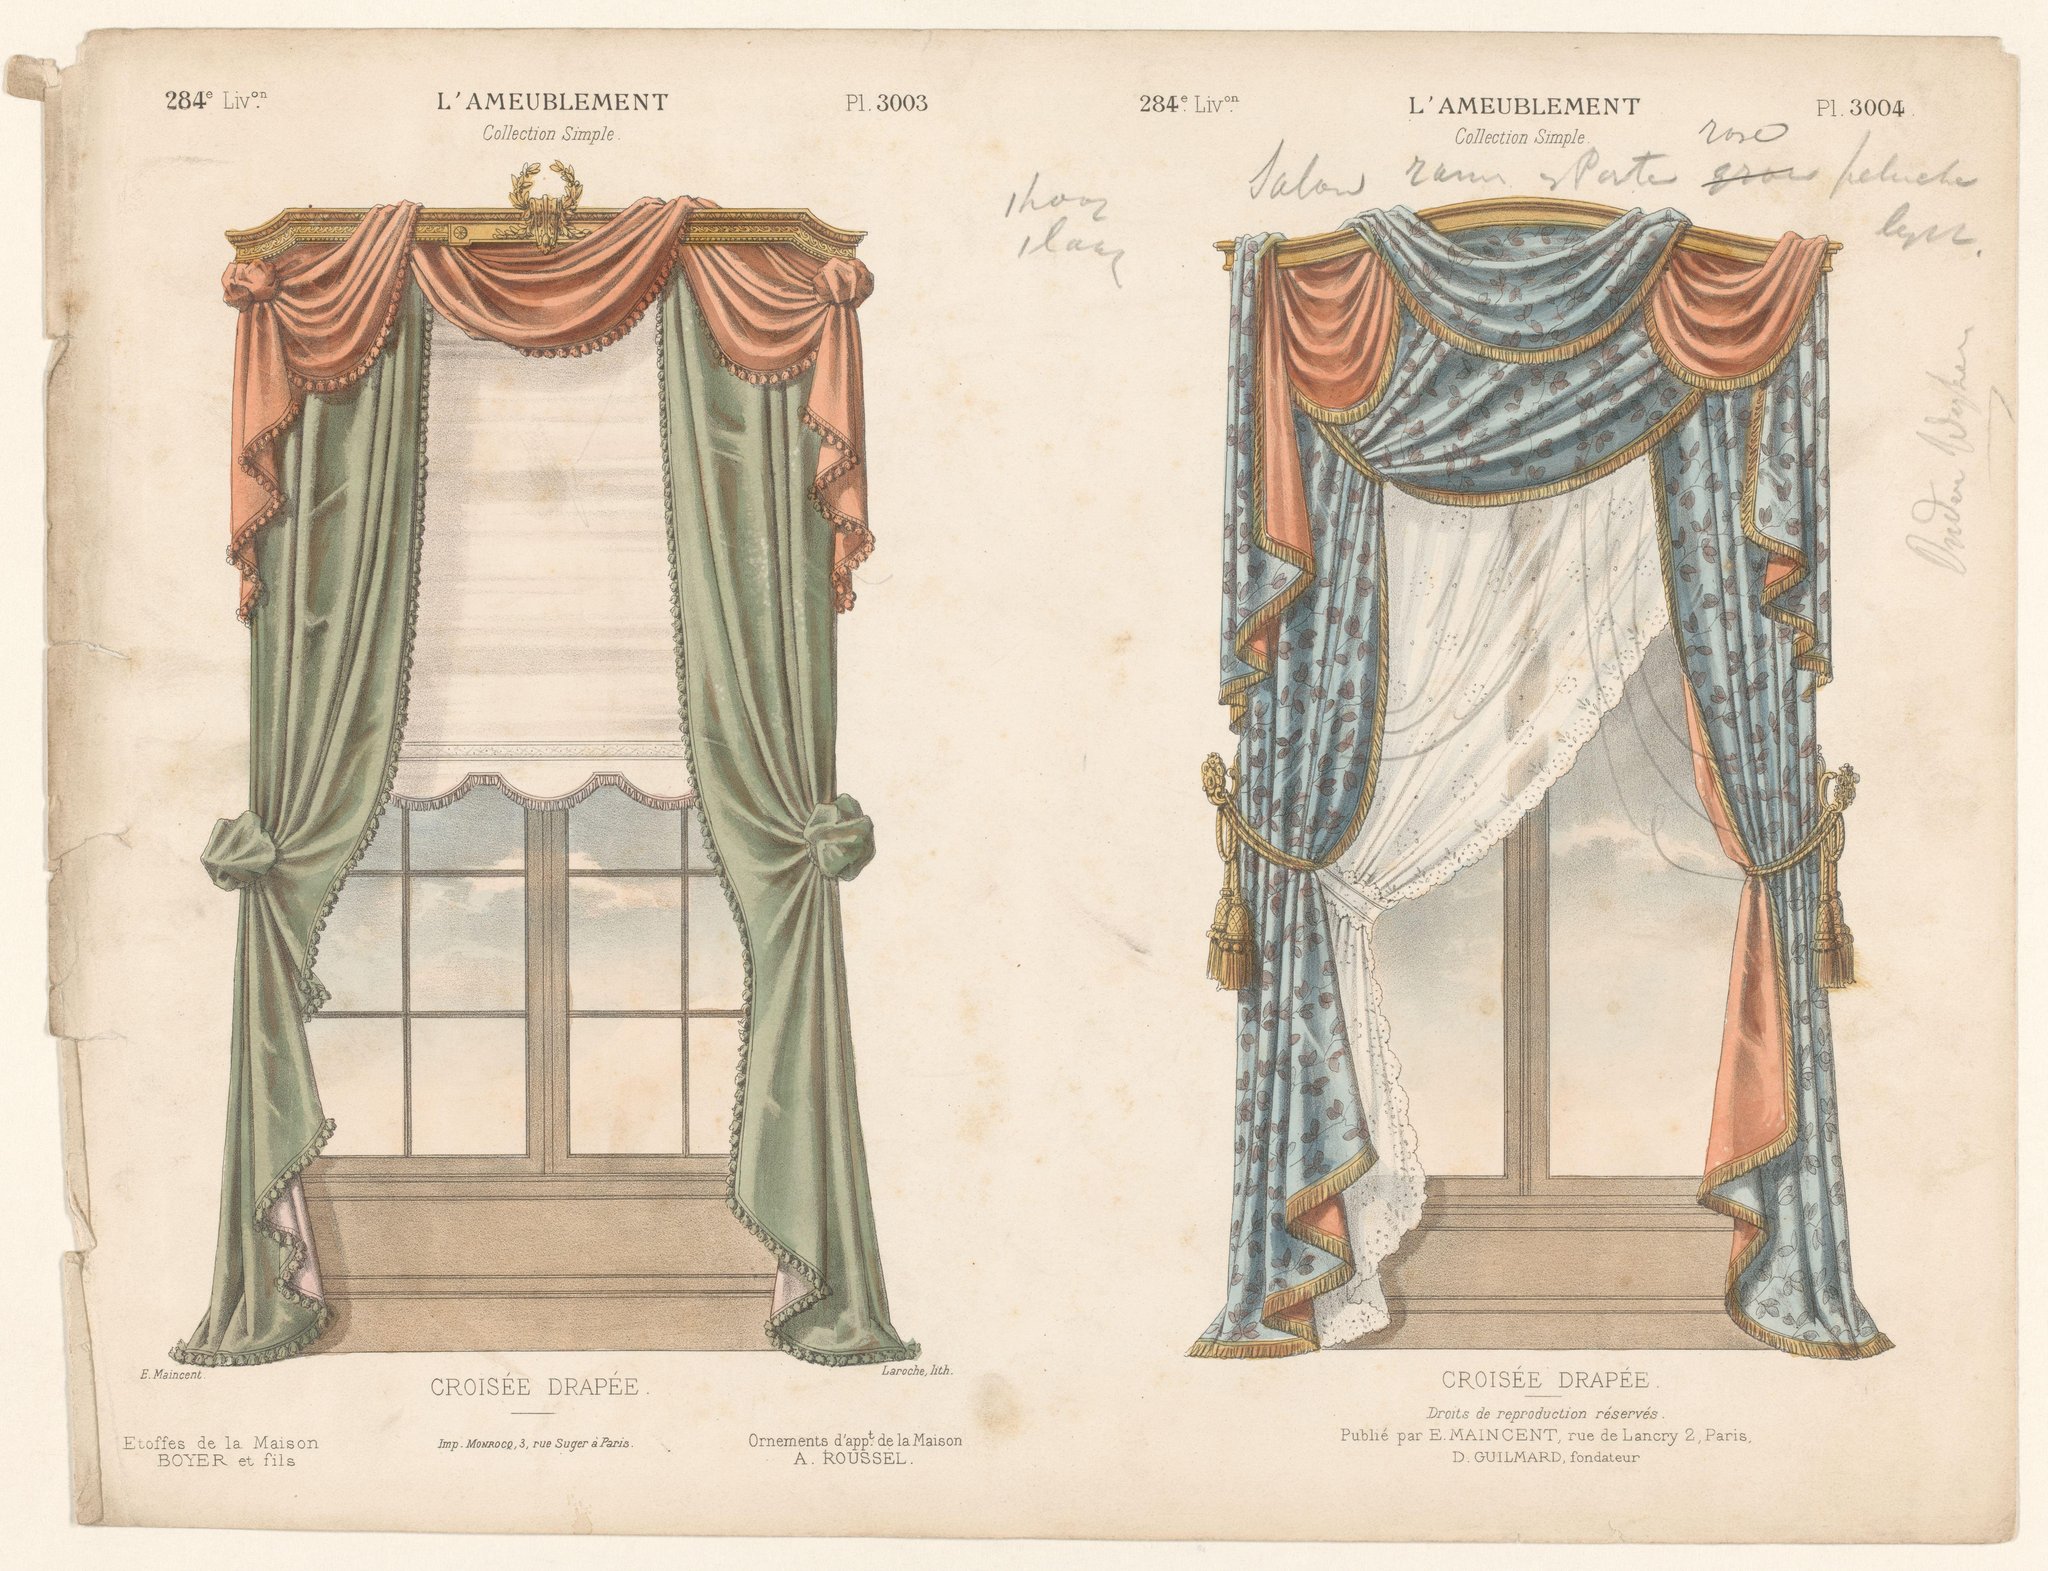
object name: print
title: Croisée drapée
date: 1885-1895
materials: paper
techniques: hand coloring, lithograph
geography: paris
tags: window, hangings and drapery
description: Twee vensters met gedrapeerde gordijnen. Prent uit 284e Livraison.